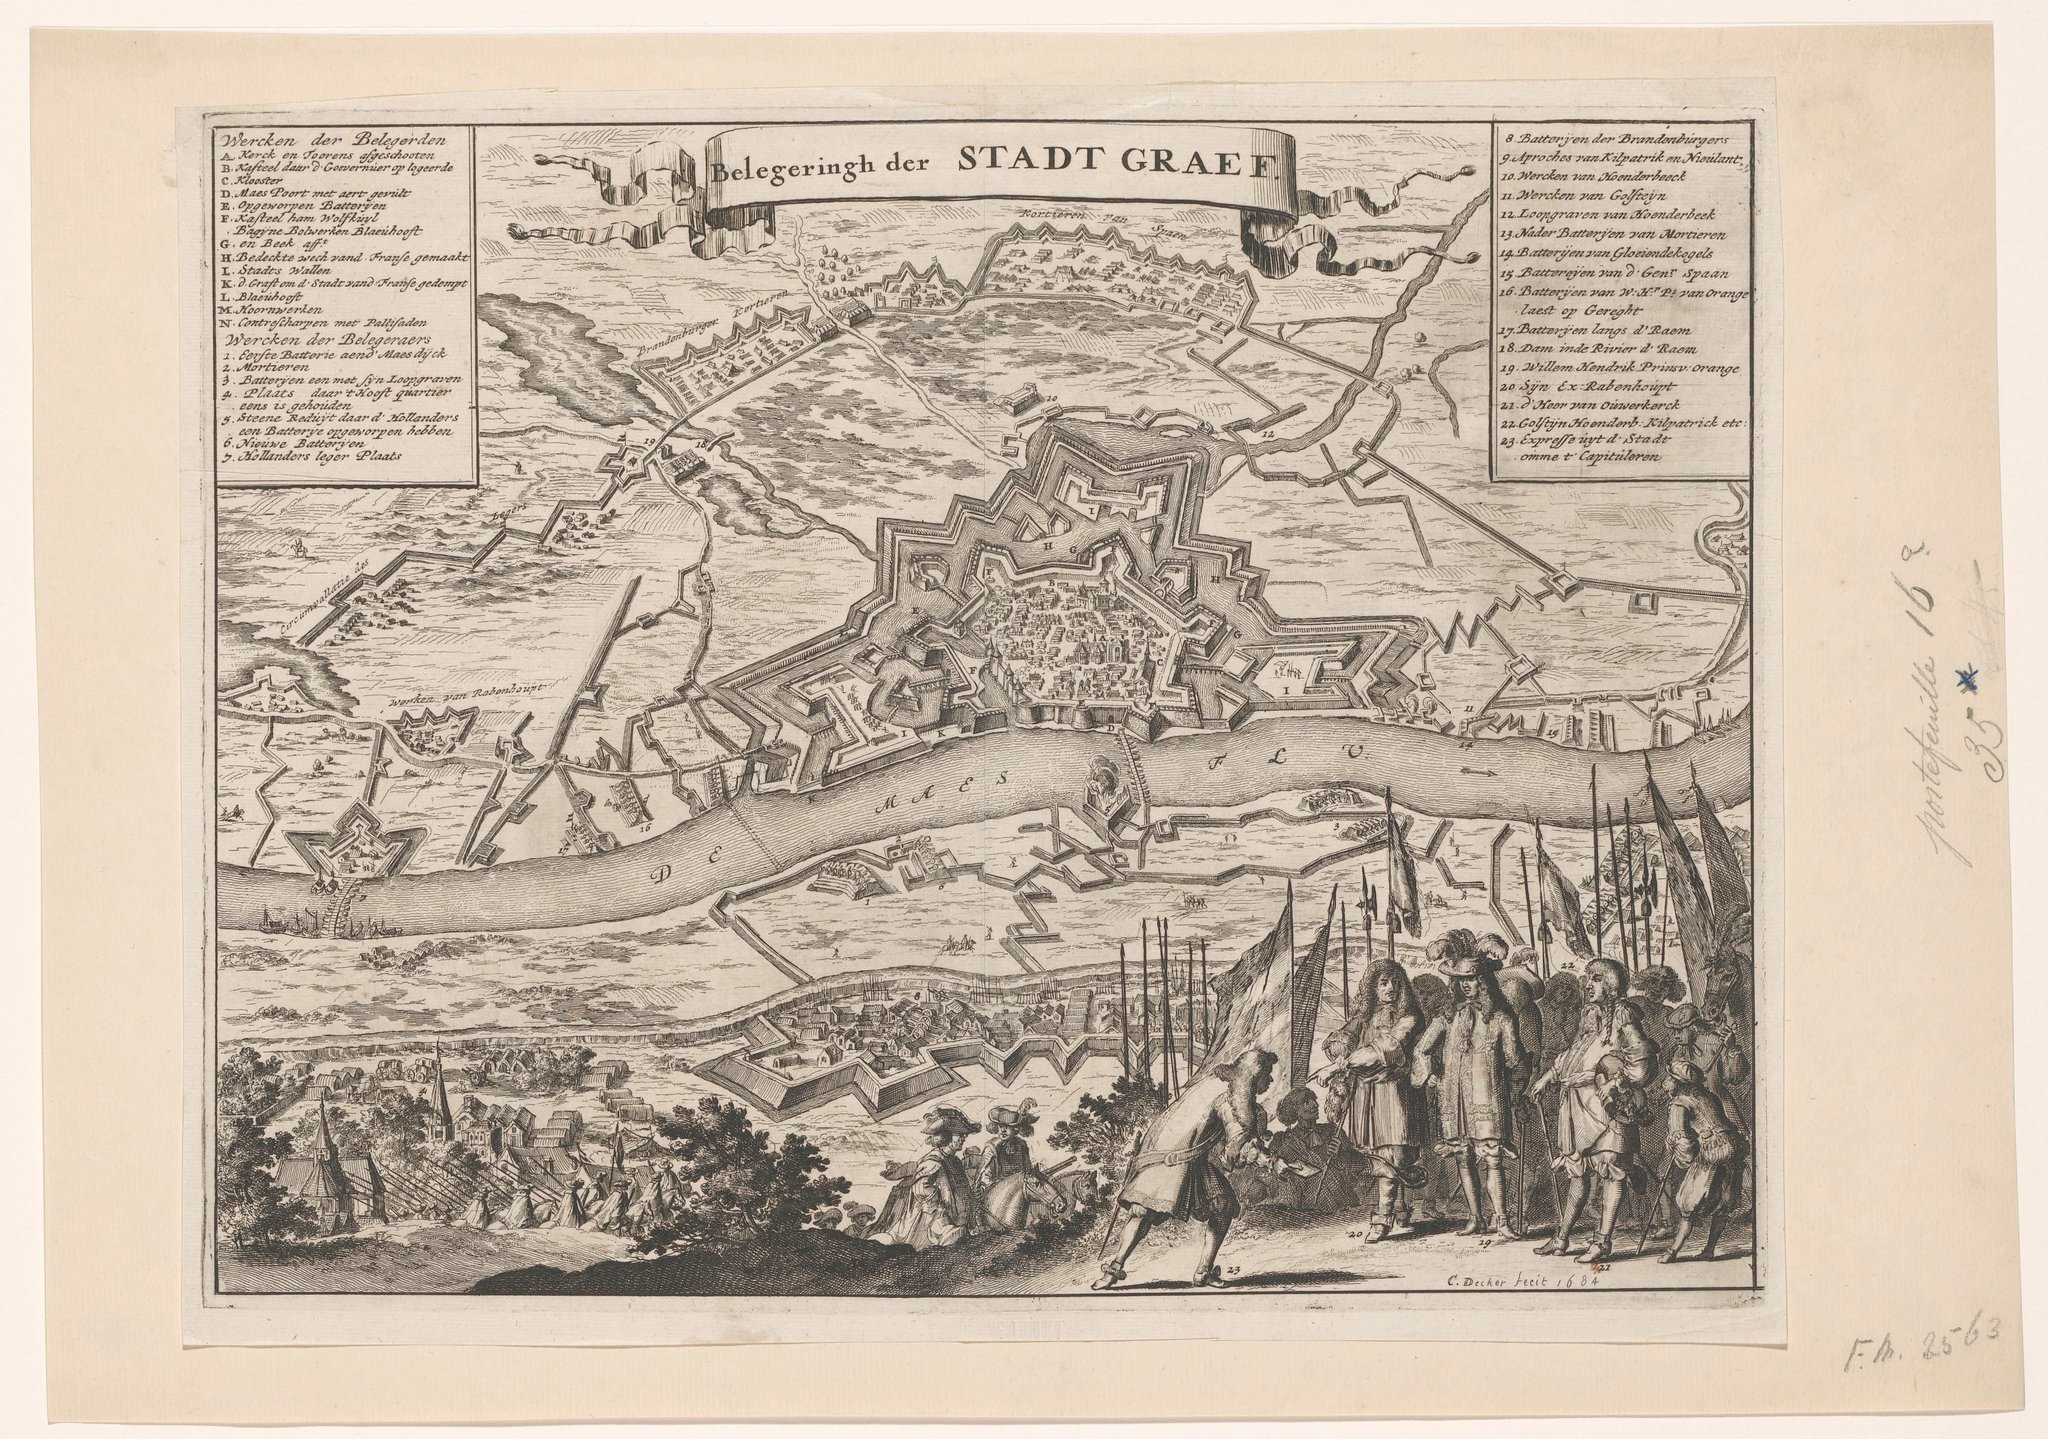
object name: history print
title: Belegeringh der stadt Graef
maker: coenraet decker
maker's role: print maker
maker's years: 1650-1685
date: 1684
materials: paper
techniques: engraving, etching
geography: amsterdam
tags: the hague, william iii (prince of orange and king of england, scotland, and ireland), siege, position war, capture of city (after the siege), maps of cities, surrender ~ war, grave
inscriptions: date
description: Het beleg en de verovering van Grave door Willem III, 25 juli tot 29 oktober 1674. Gezicht op de belegering van de stad aan de Maas. Op de voorgrond overhandigt een afgevaardigde van de stad het verzoek om overgave aan Willem III. Linksboven een legenda A-N en 1-7, rechtsboven een legenda 8-23.